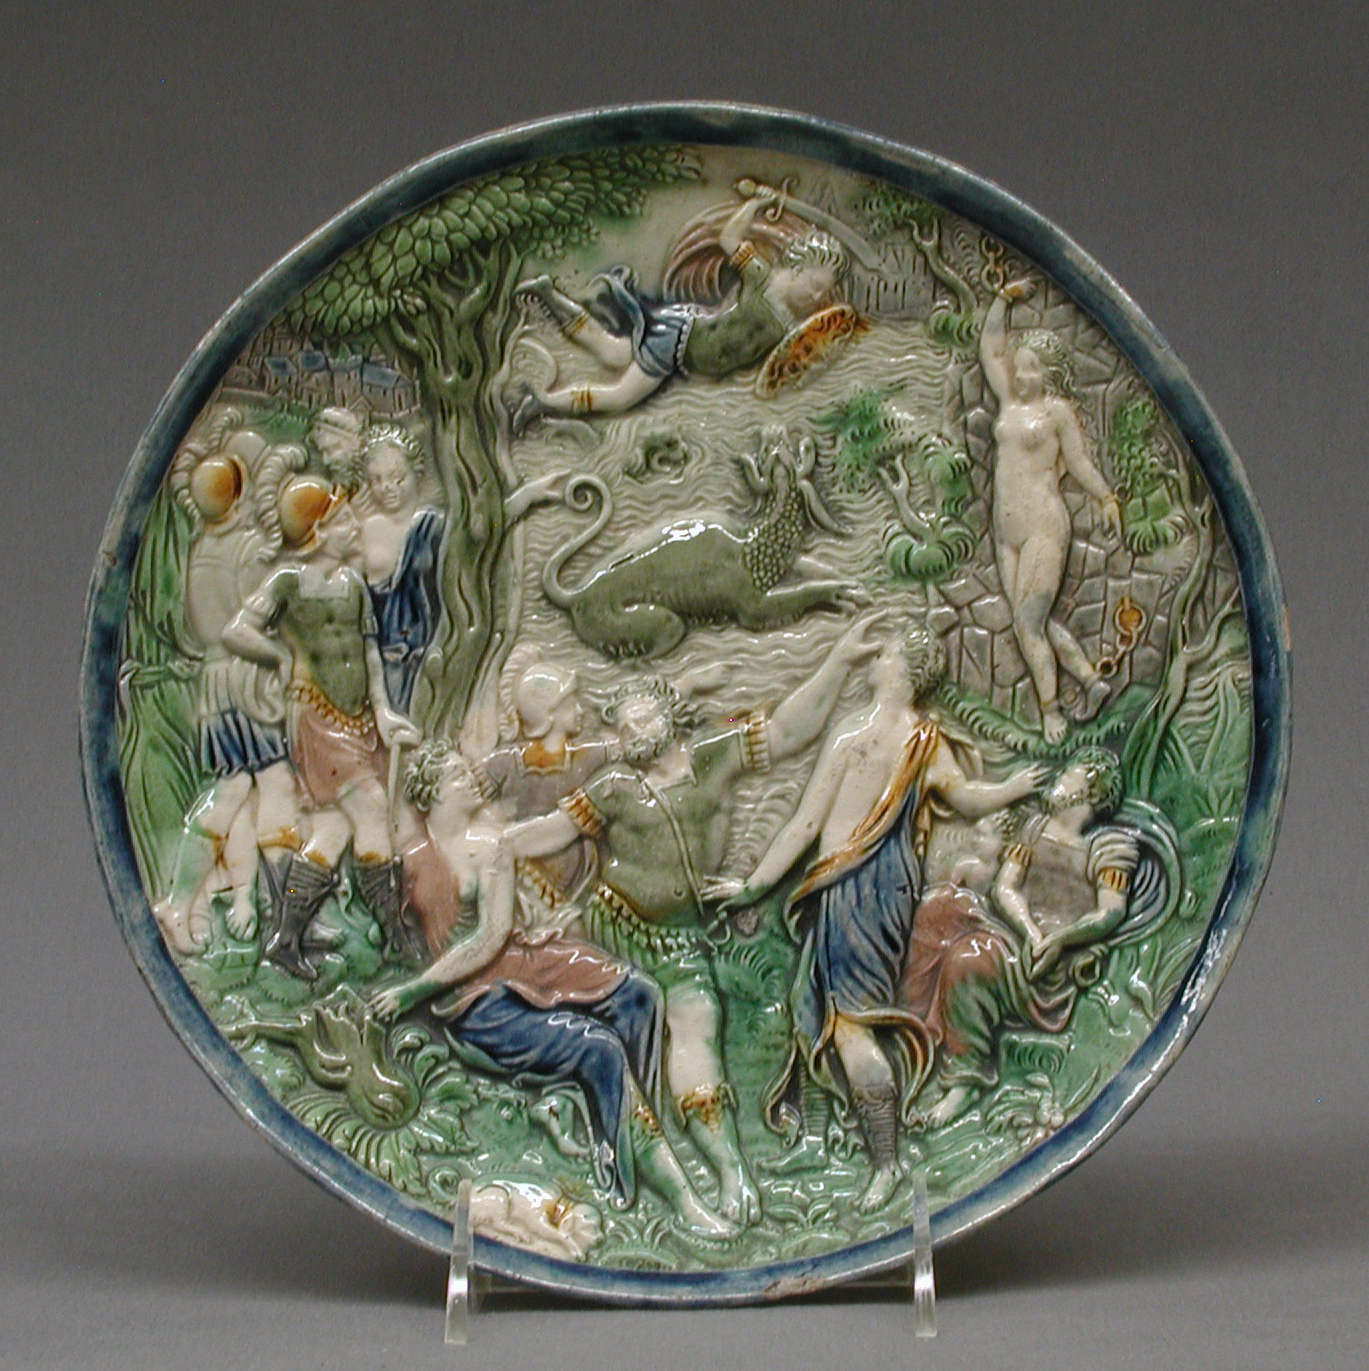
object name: plate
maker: bernard palissy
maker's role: maker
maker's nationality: french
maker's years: 1510-1590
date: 1567-1633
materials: earthenware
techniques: glazing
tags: animals,men,female nudes